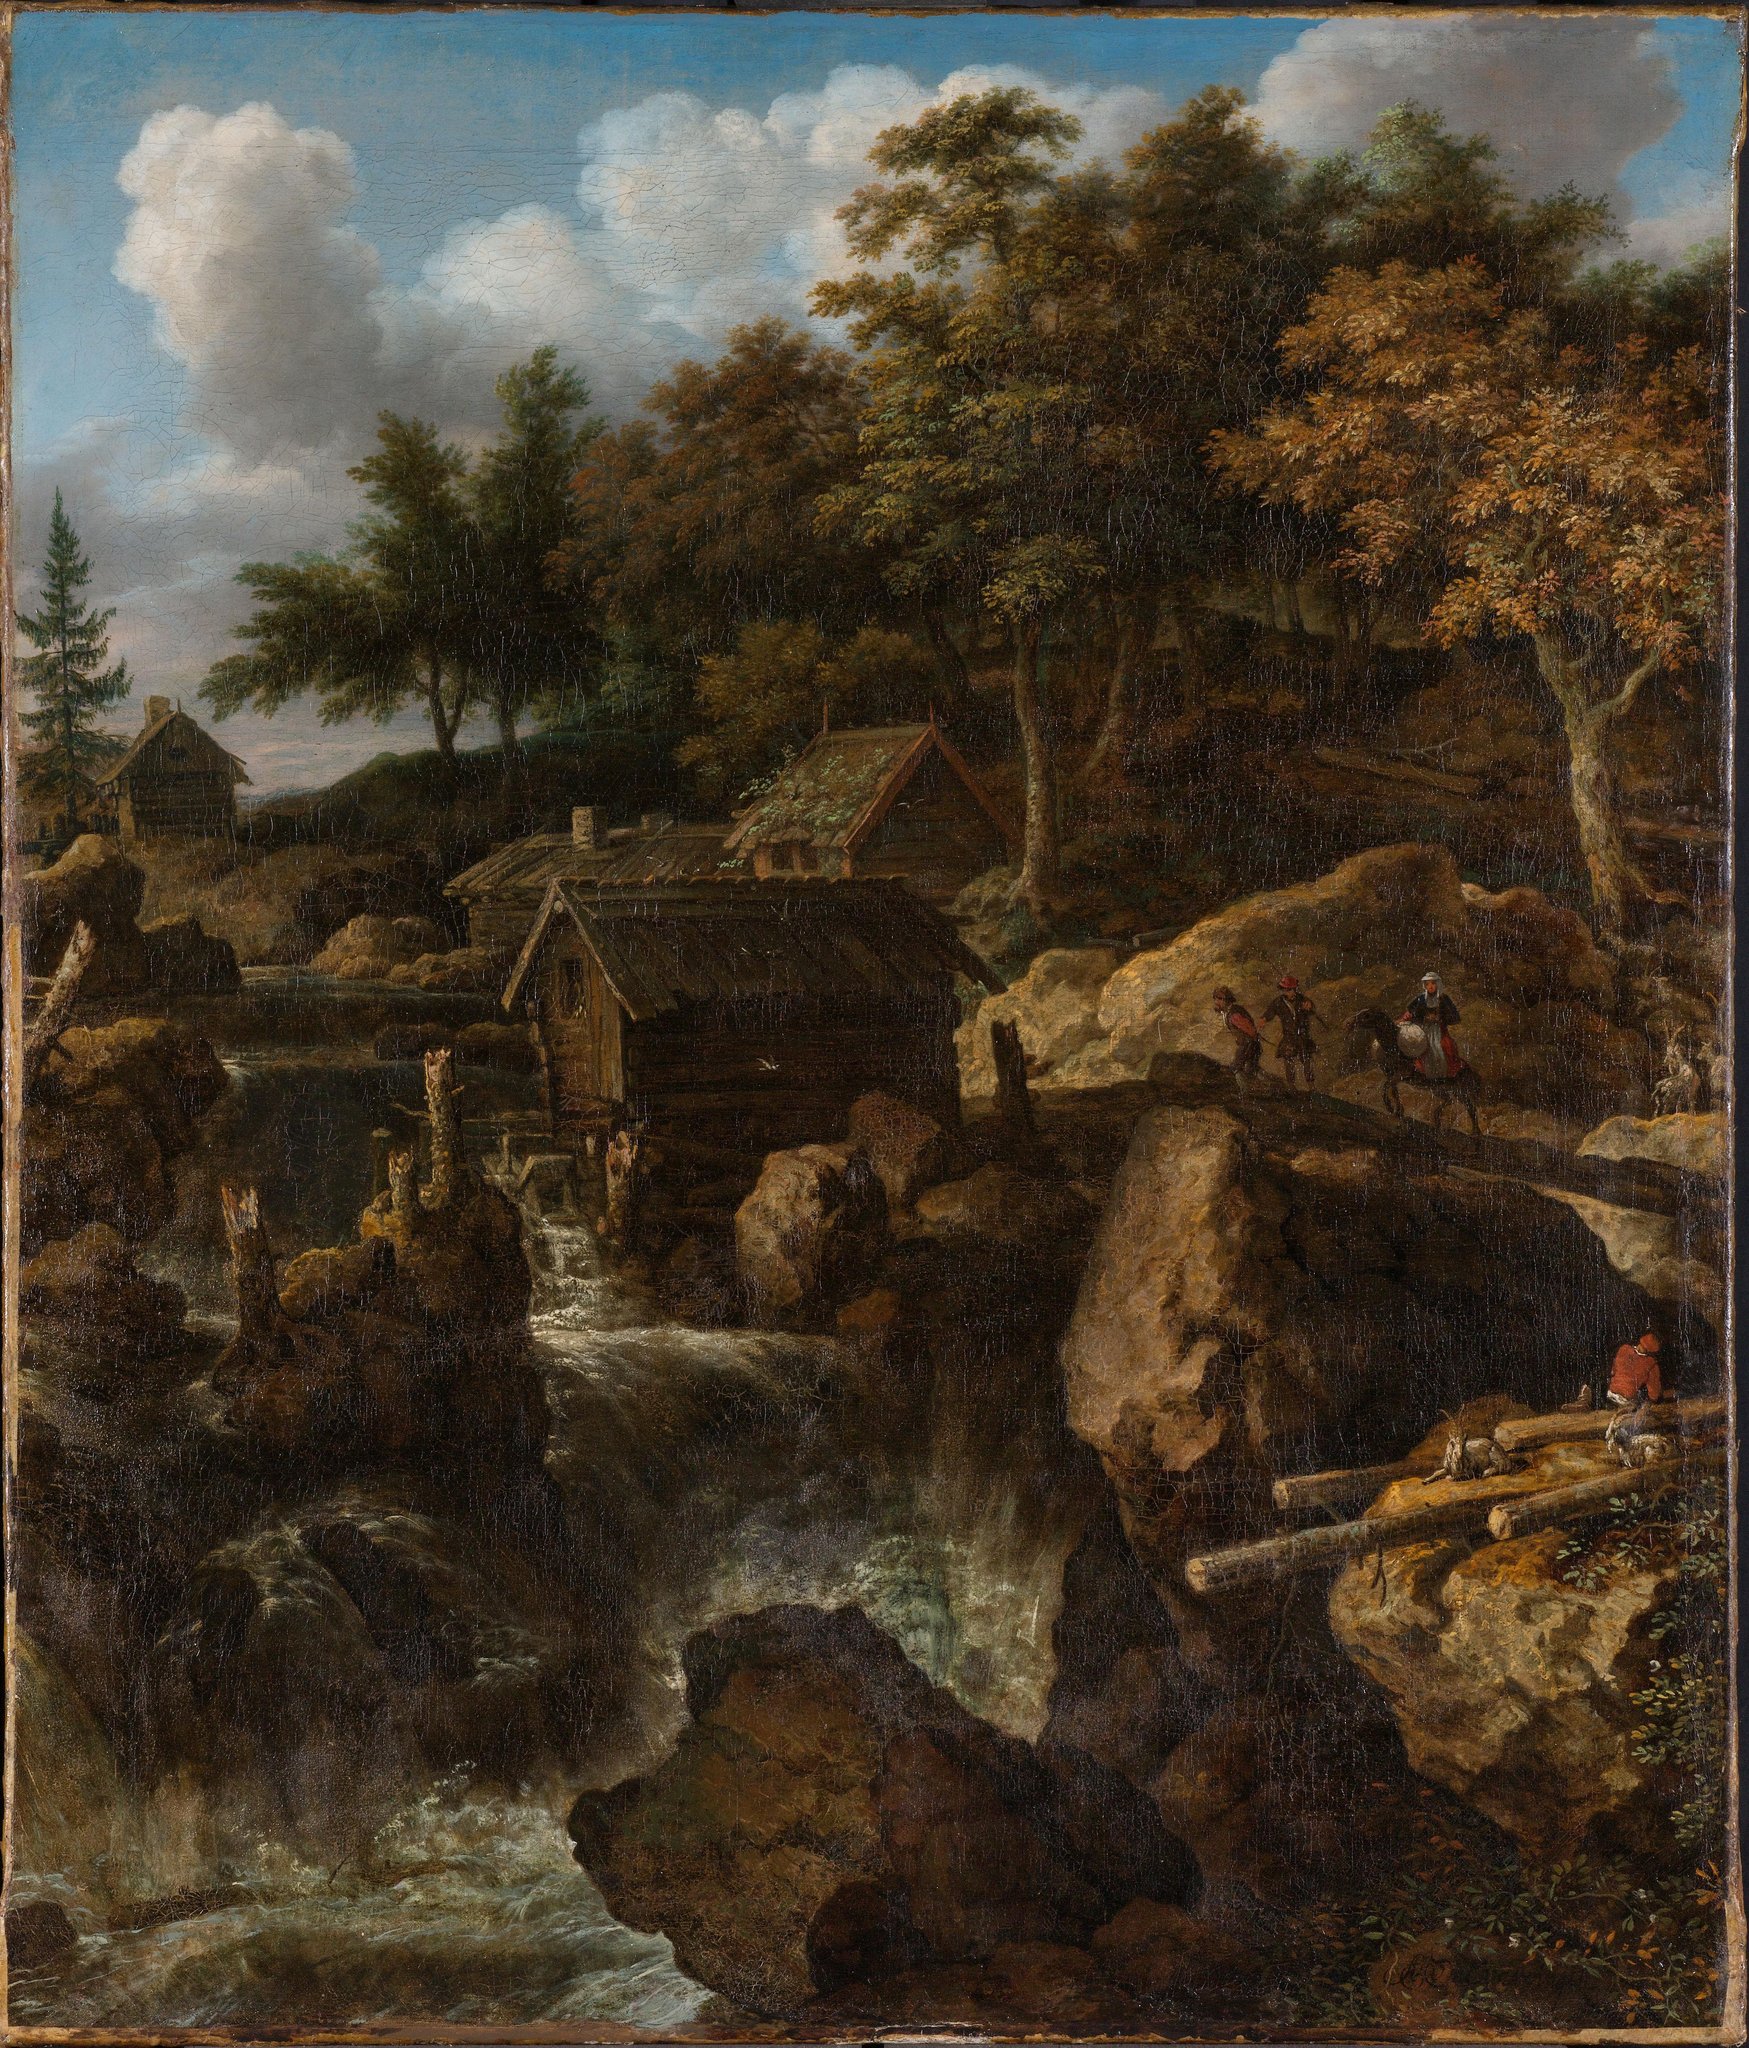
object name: painting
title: Swedish Landscape with a Waterfall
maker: allaert van everdingen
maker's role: draughtsman, painter, print maker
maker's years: 1621-1675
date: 1650-1675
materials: canvas, oil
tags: waterfall, rocks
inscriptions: signature: ‘A. V. Everdingen’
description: Zweeds landschap met waterval aan de rand van een bos. Langs enige huisjes stort een rivier tussen grote rotsblokken naar beneden. Enige figuren lopen over een houten bruggetje tussen de rotsen.